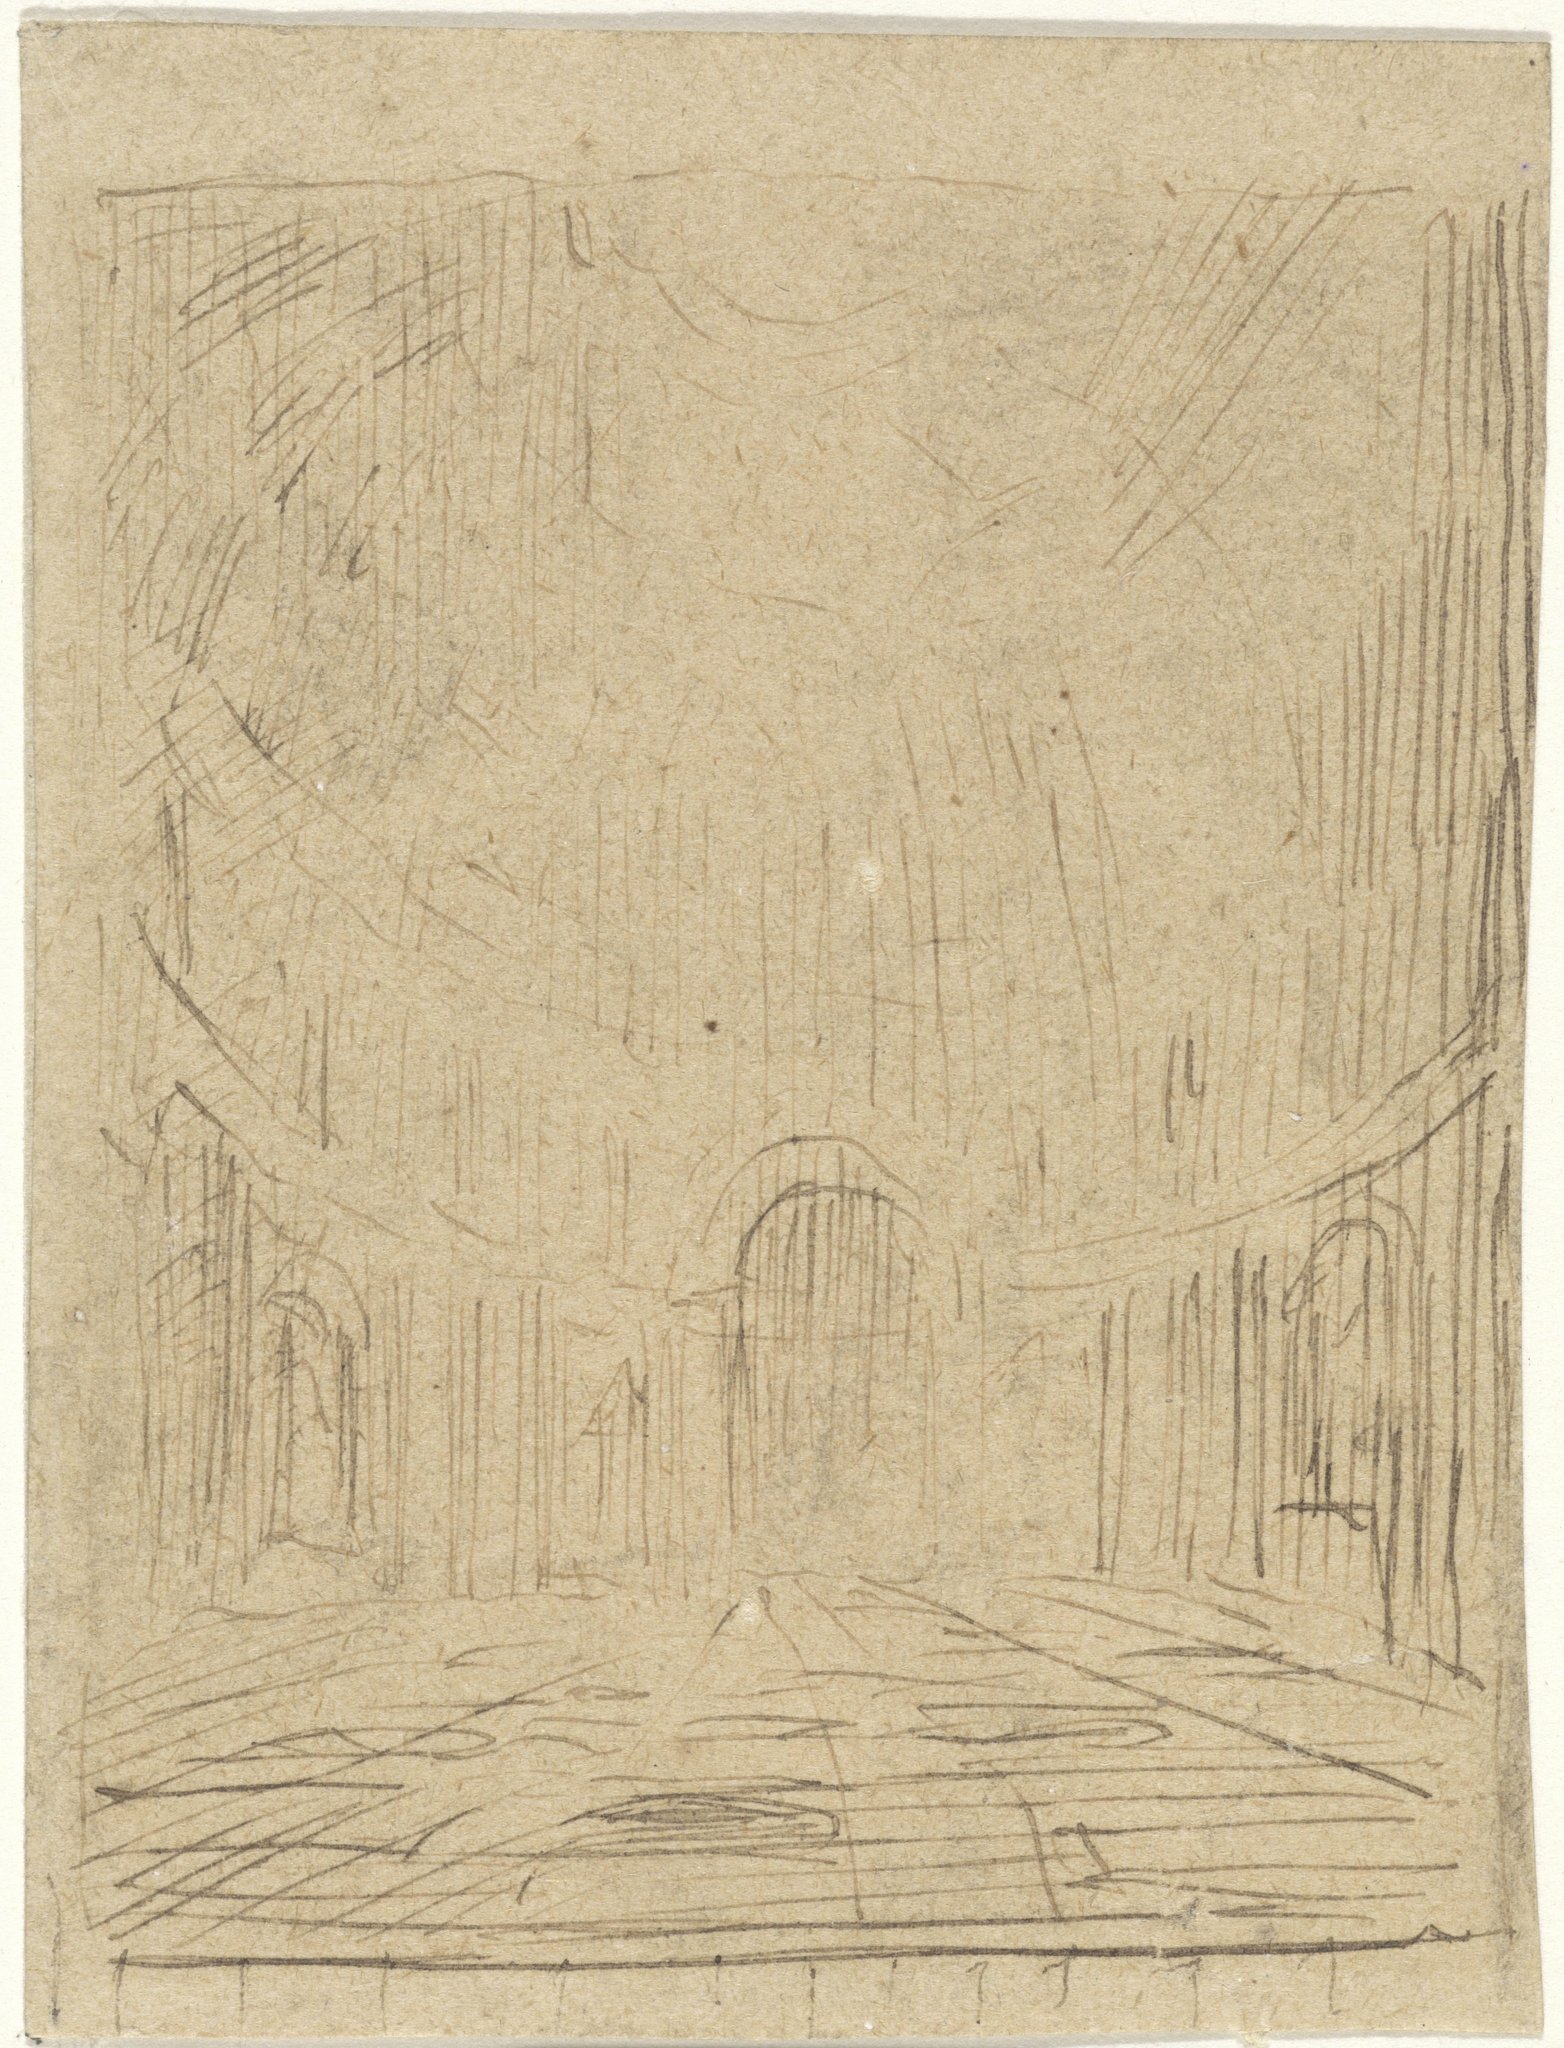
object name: drawing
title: Kerkinterieur met koepel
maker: thomas cool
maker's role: draughtsman, painter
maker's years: 1851-1904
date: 1861-1904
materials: ink, paper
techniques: pen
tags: interior of church, rome